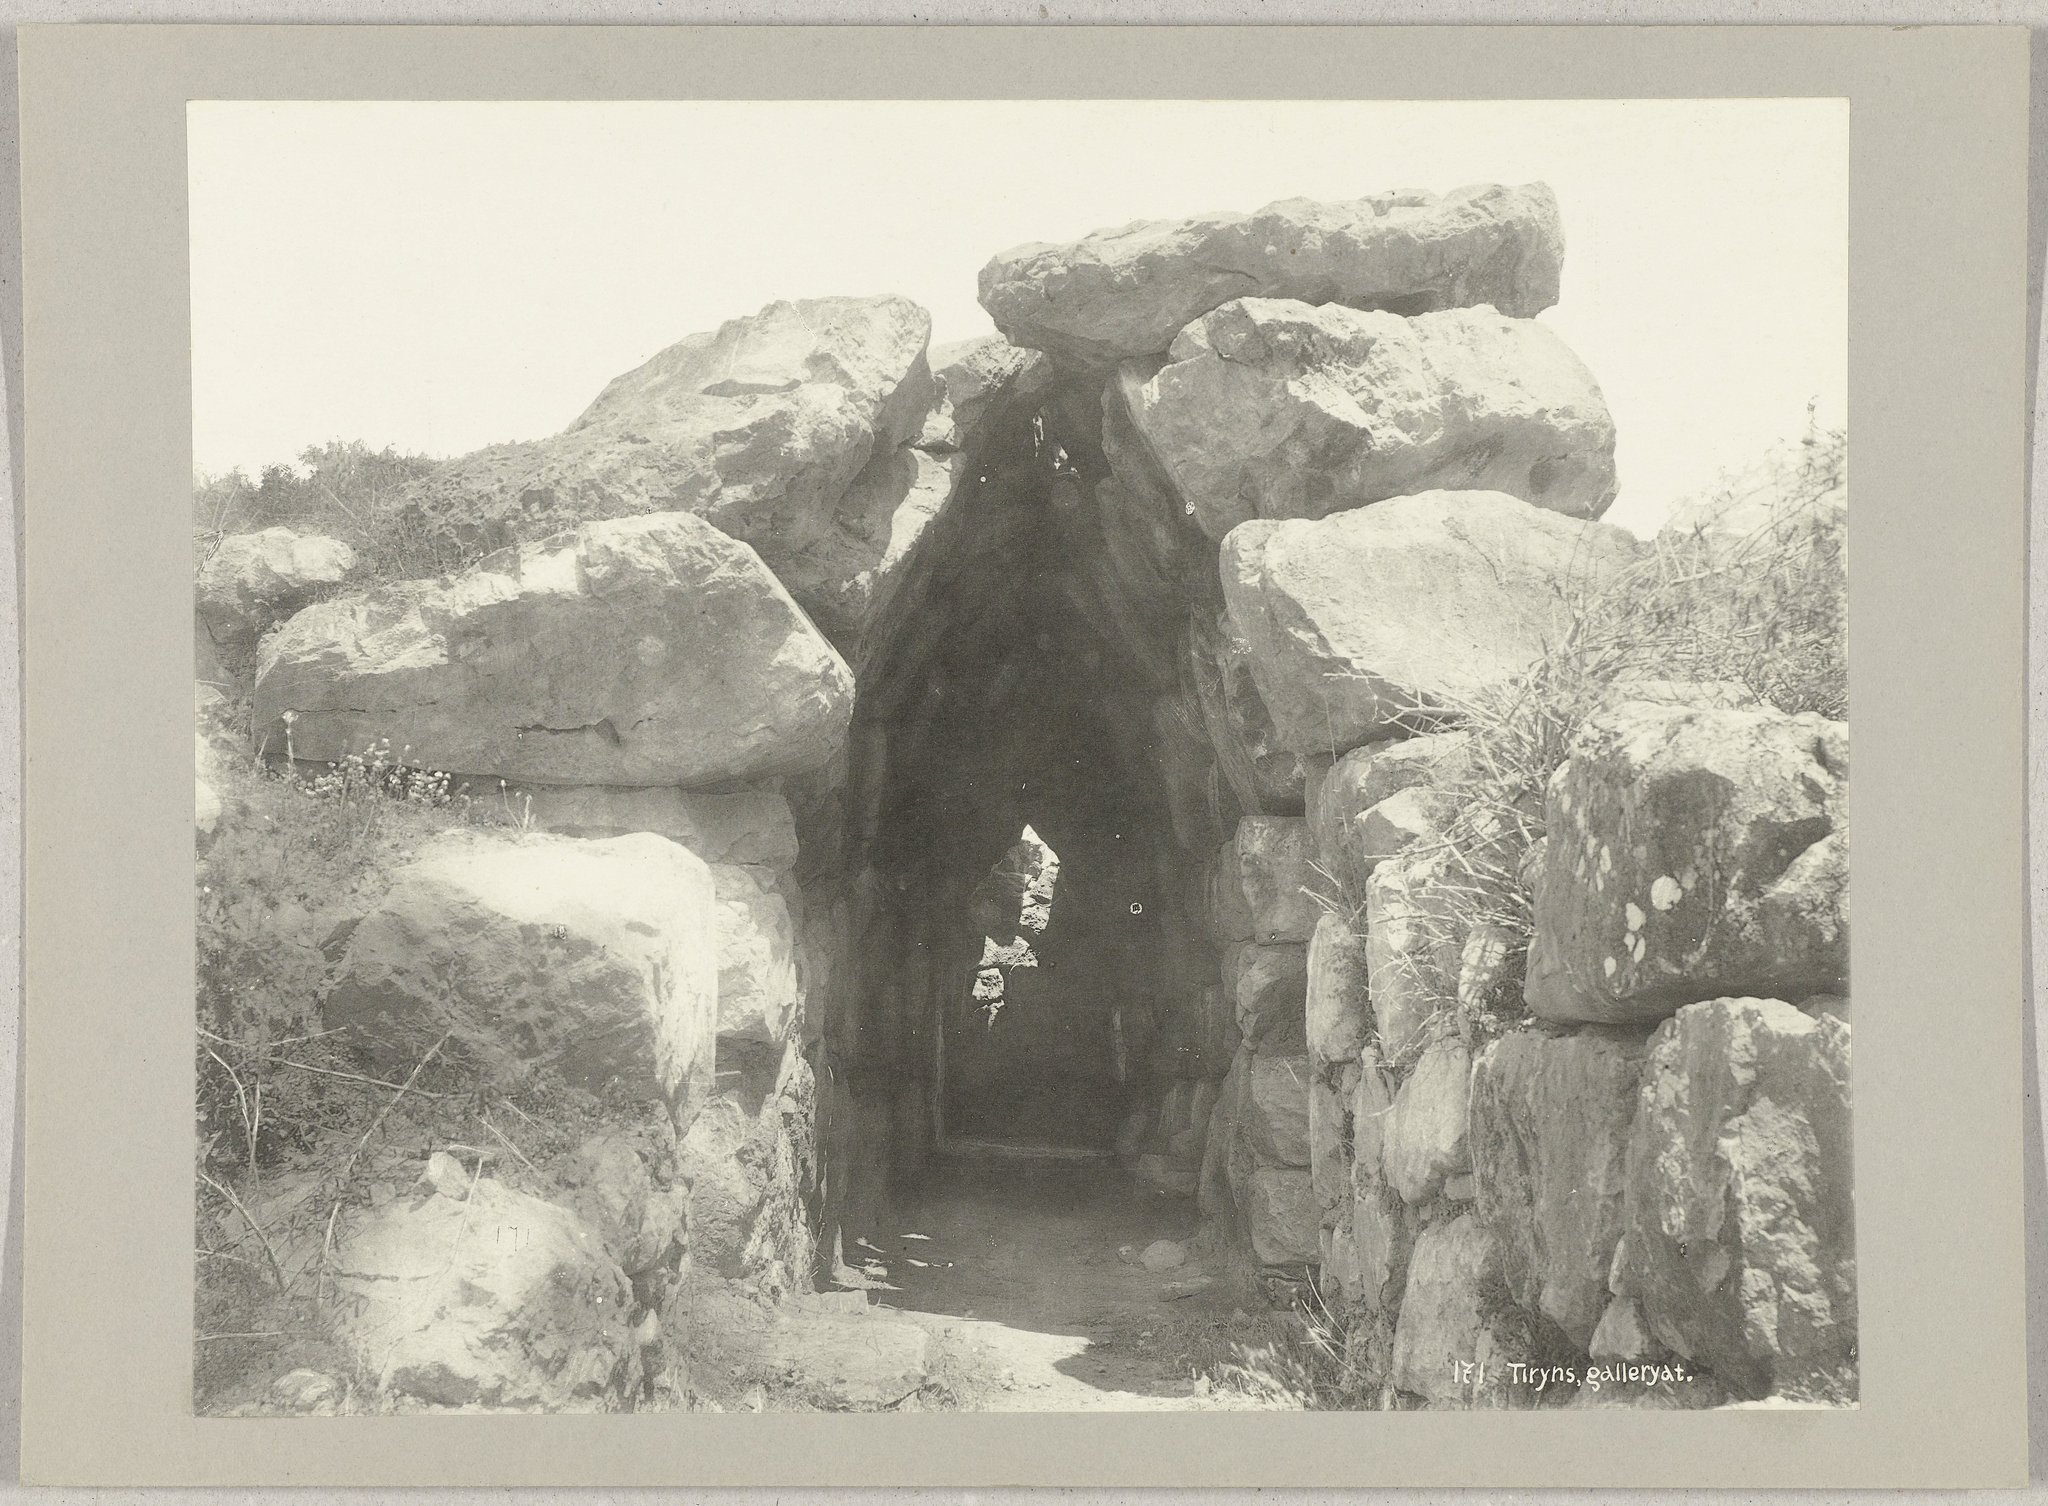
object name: photograph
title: Gallerij van Tiryns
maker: Anonymous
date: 1895-1915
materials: cardboard, paper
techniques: photograph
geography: argos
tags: árgos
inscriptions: annotation: ‘9. Tyrinthe. Oude galerij der acropolis.’